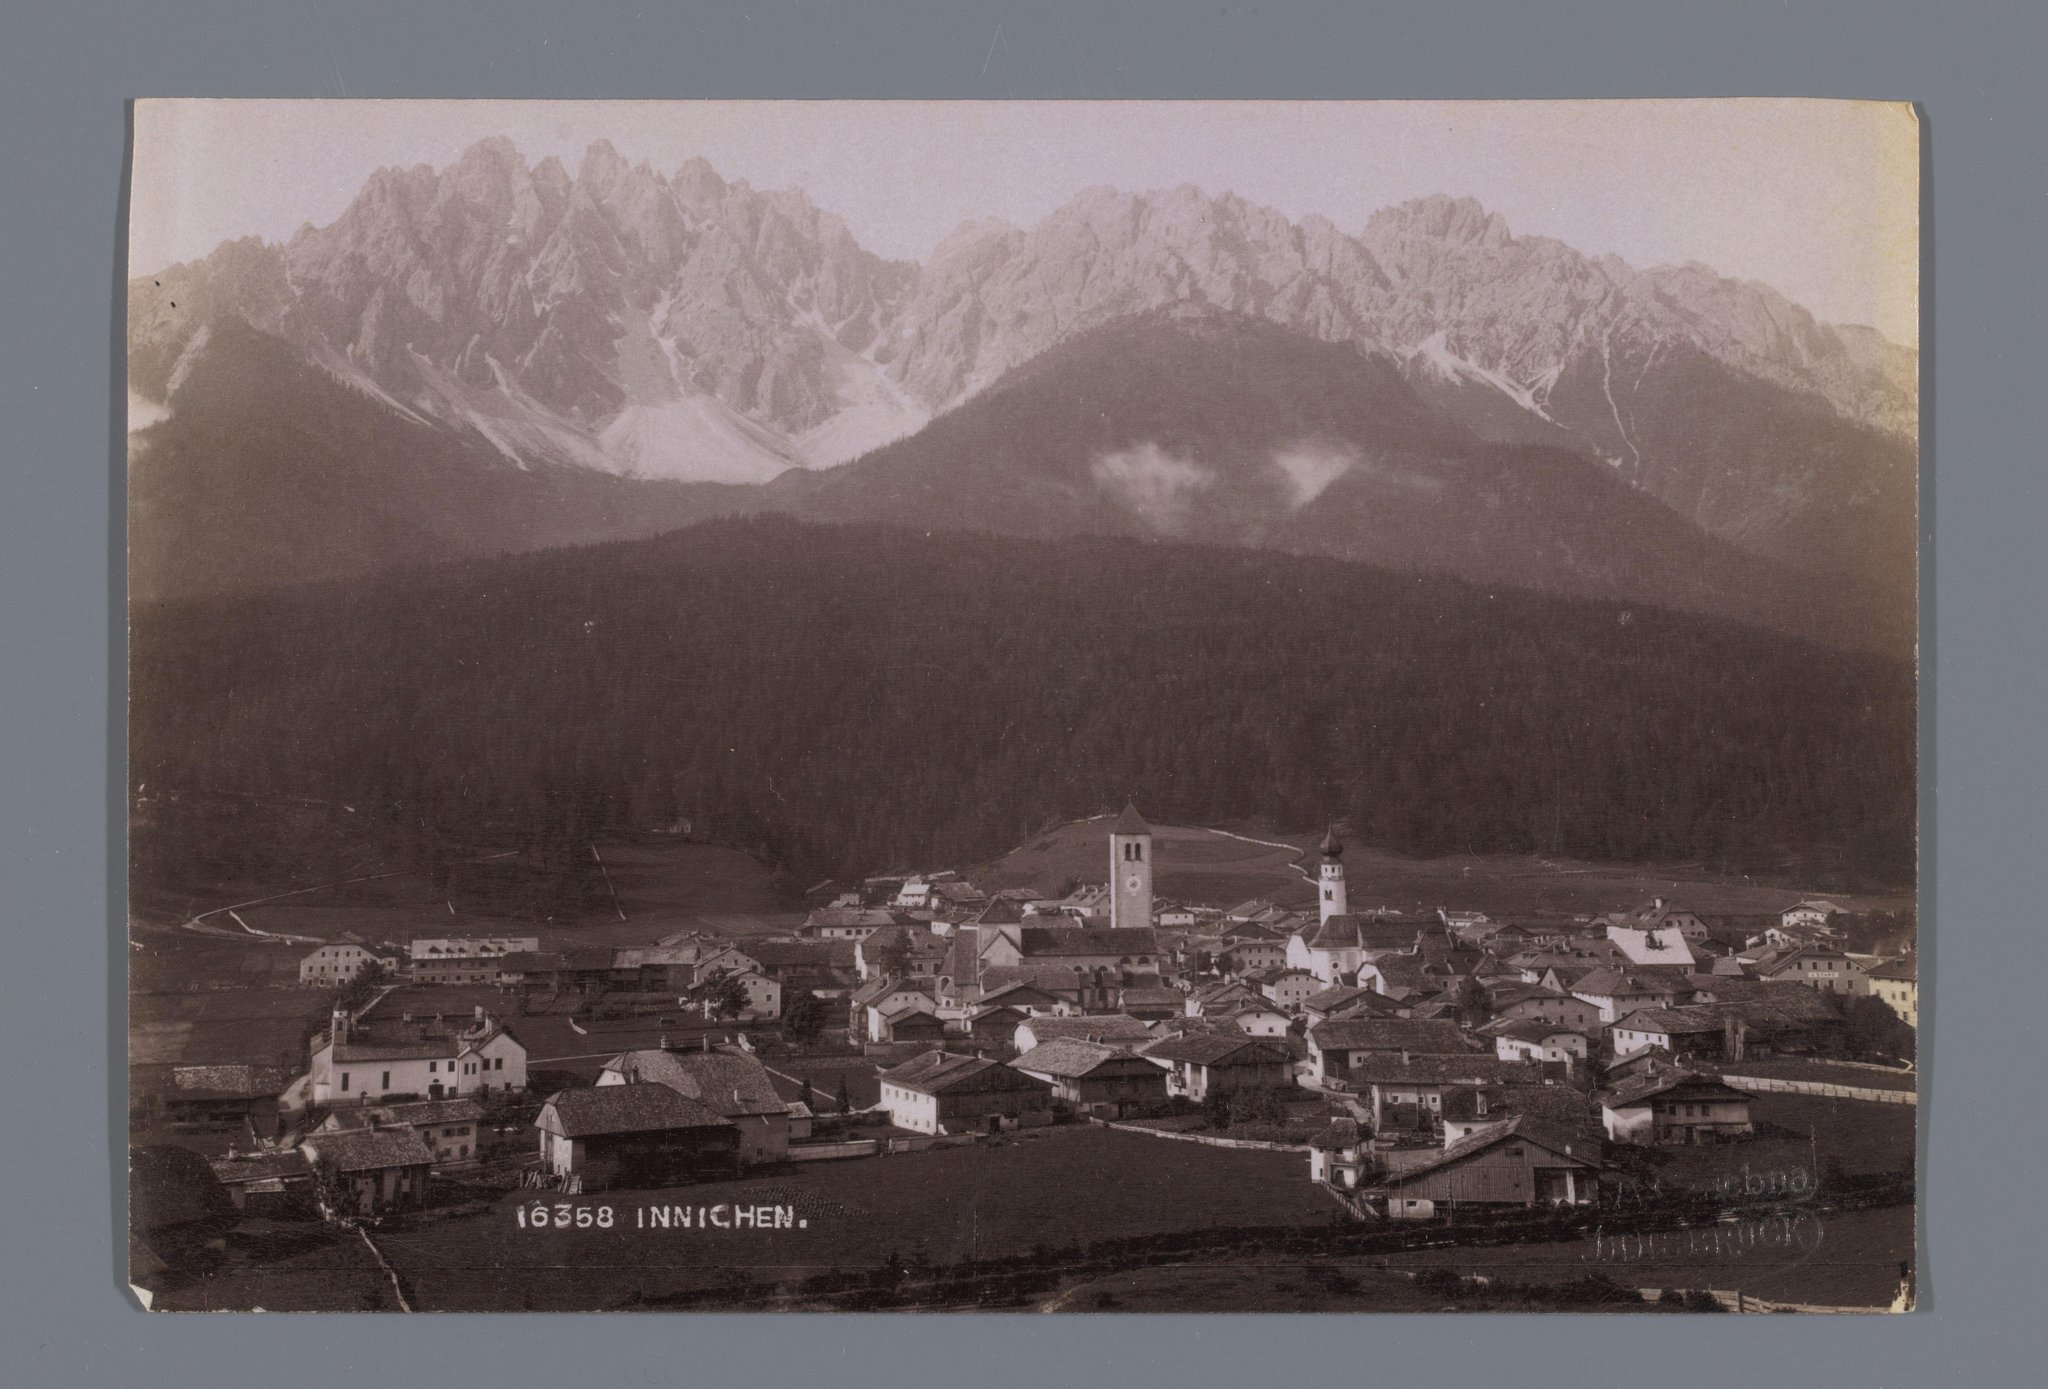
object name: photograph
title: Gezicht op het dorp Innichen, Italië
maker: carl alexander czichna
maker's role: publisher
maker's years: 1811-1867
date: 1860-1867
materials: paper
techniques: albumen print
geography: innichen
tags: dale, valley, city-view in general; 'veduta', mountains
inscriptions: number: ‘16358’